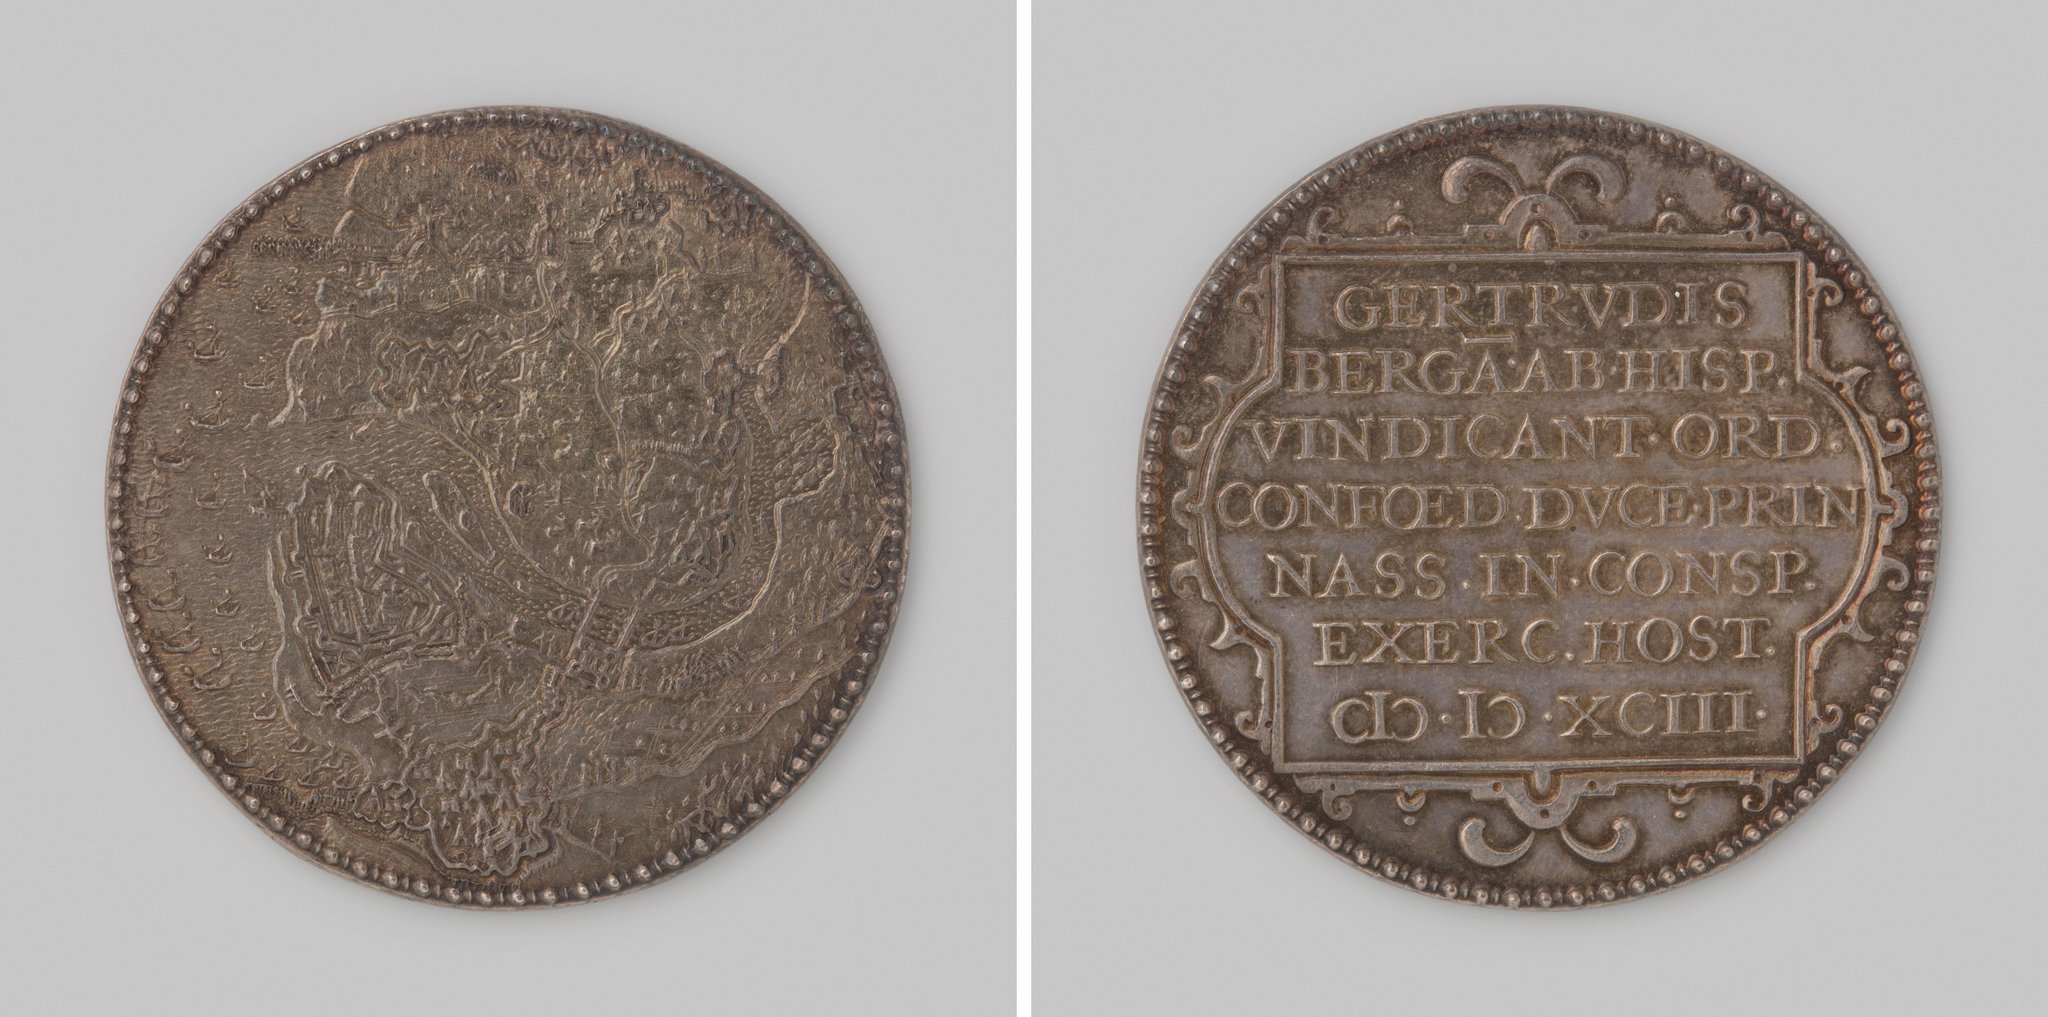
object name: history medal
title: Beleg van Geertruidenberg door Prins Maurits 1593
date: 1593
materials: silver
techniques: striking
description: Zilveren penning, op de voorzijde de plattegrond van het belegerde Geertruidenberg, met omschrift, op de keerzijde zeven regels tekst in een versierde rechthoek